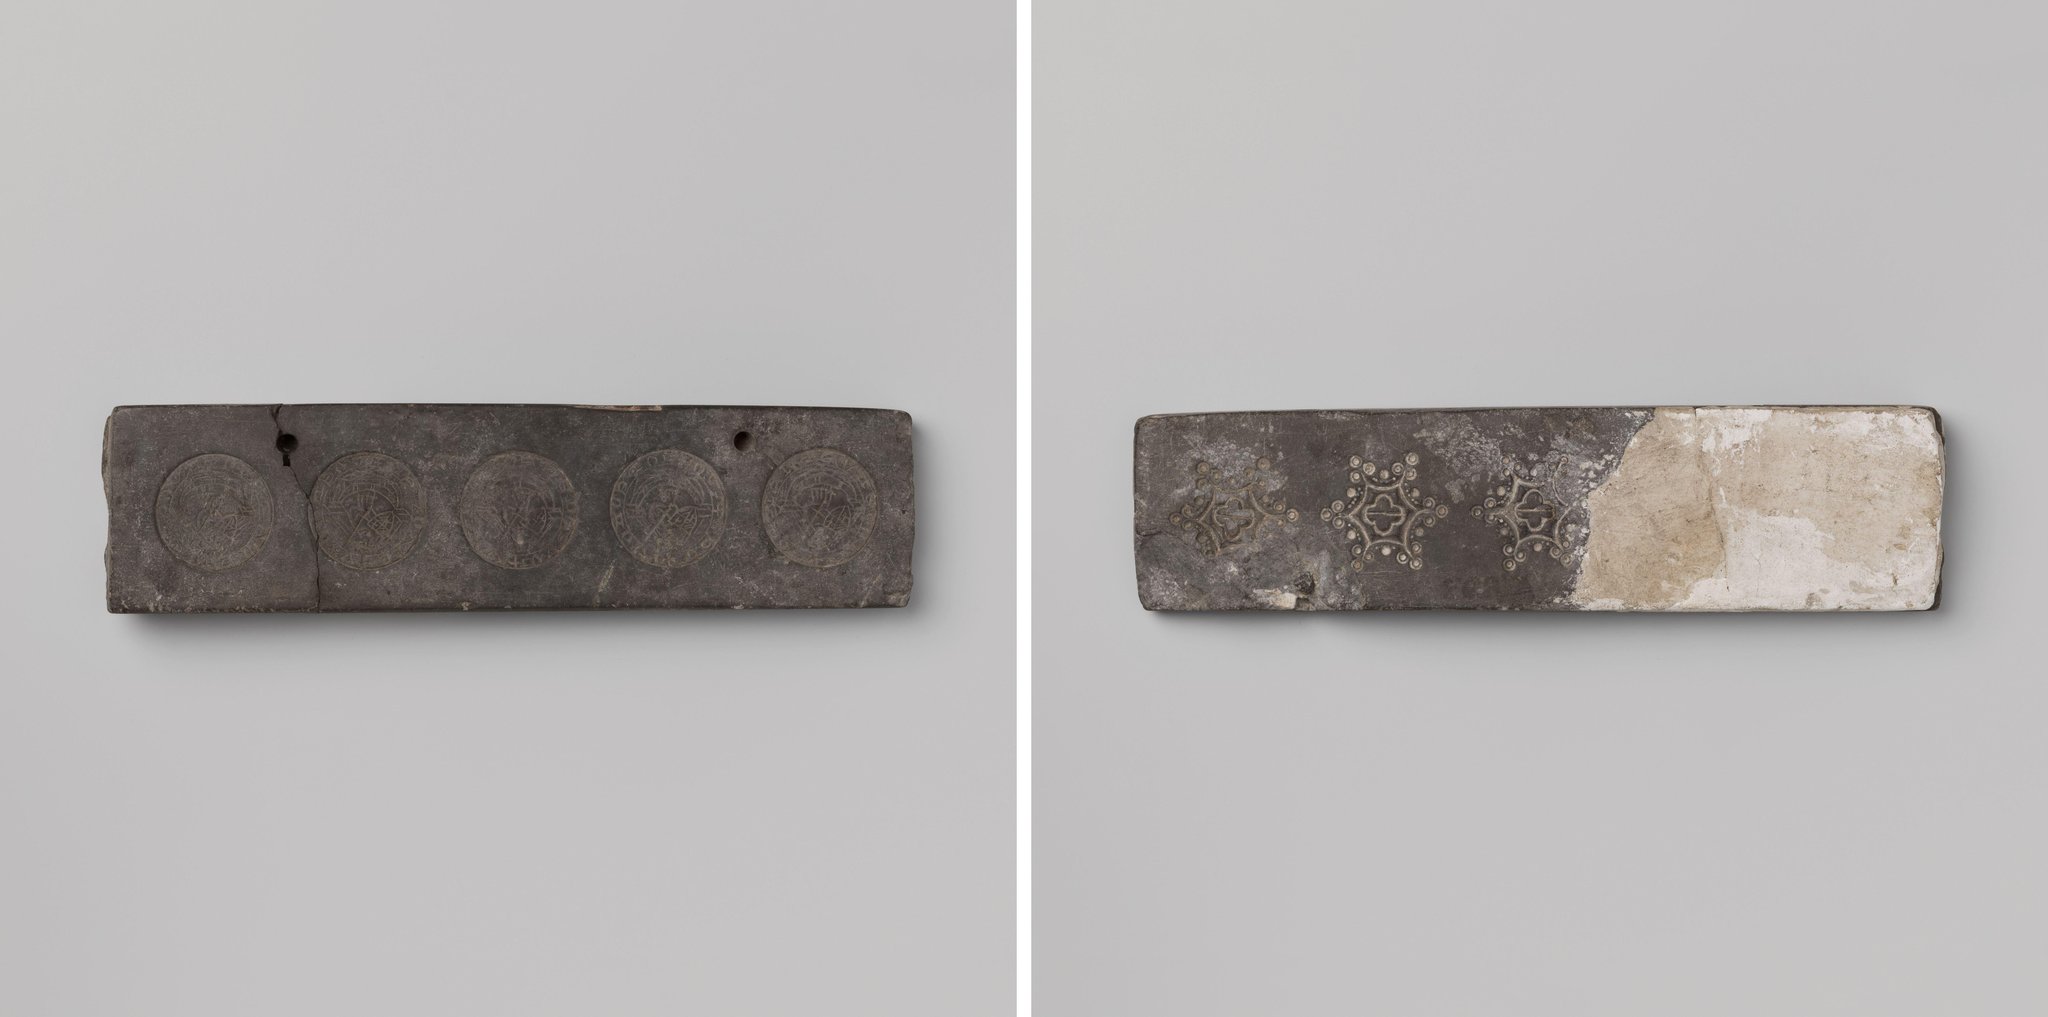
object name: rozenobel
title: Blok voor vervaardiging van munten (type rozenobel), afkomstig van opgravingen bij het klooster van Diepenveen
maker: Anonymous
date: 1340-1450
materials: gypsum, stone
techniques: grinding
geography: diepenveen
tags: diepenveen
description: Langwerpig blok van leisteen, met aan bovenzijde vijf afbeeldingen van munten (rozenobel) en aan onderzijde vijf identieke siermotieven, waarvan er als gevolg van beschadiging nog drie zichtbaar zijn; aan bovenkant: twee kleine openingen, die aan een van zijkanten uitkomen.